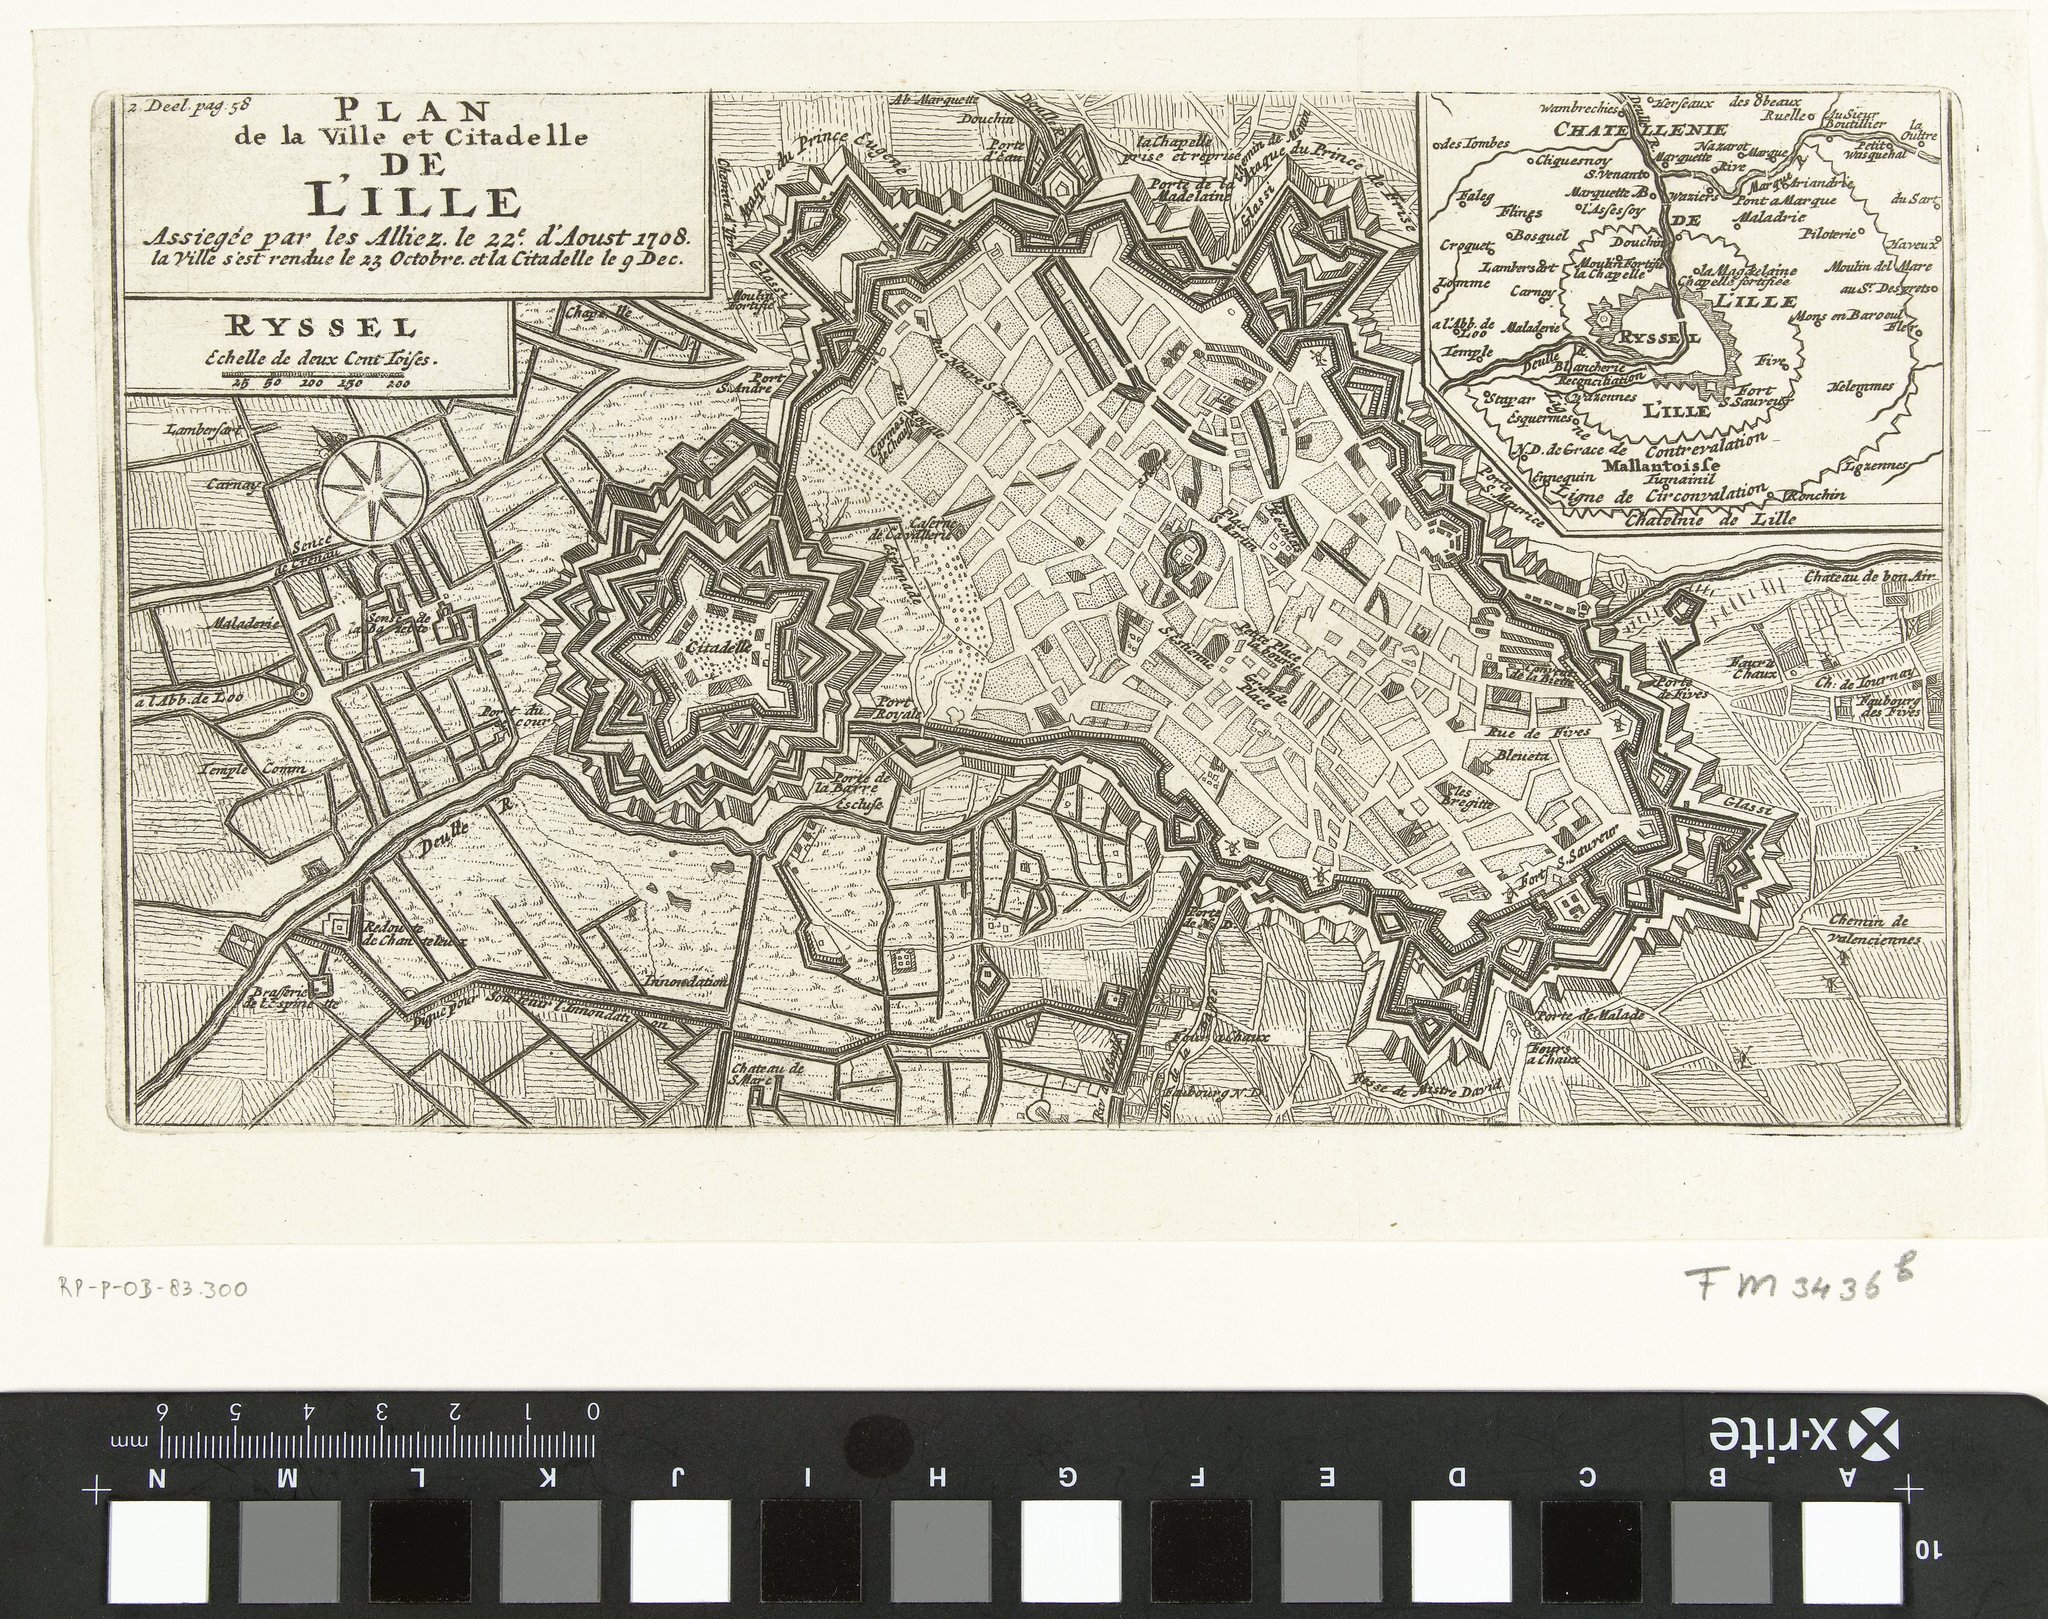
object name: map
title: Plan de la Ville et Citadelle de L'ille Assiegée par les Alliez. le 22e. d'Aoust 1708. la Ville s'est rendue le 23 Octobre. et al Citadelle le 9 Dec.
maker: Anonymous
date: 1708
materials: paper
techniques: etching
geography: northern netherlands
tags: johan willem friso (prins van oranje-nassau), paris, eugenius van savoye, maps of cities, lille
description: Plattegrond van Rijssel (Lille), belegerd vanaf 22 augustus 1708 door de Geallieerden onder prins Eugenius van Savoye en prins Johan Willem Friso. Rechtsboven een inzet met een kaart van het groter gebied. Gemerkt linksboven: 2 Deel. pag. 58.